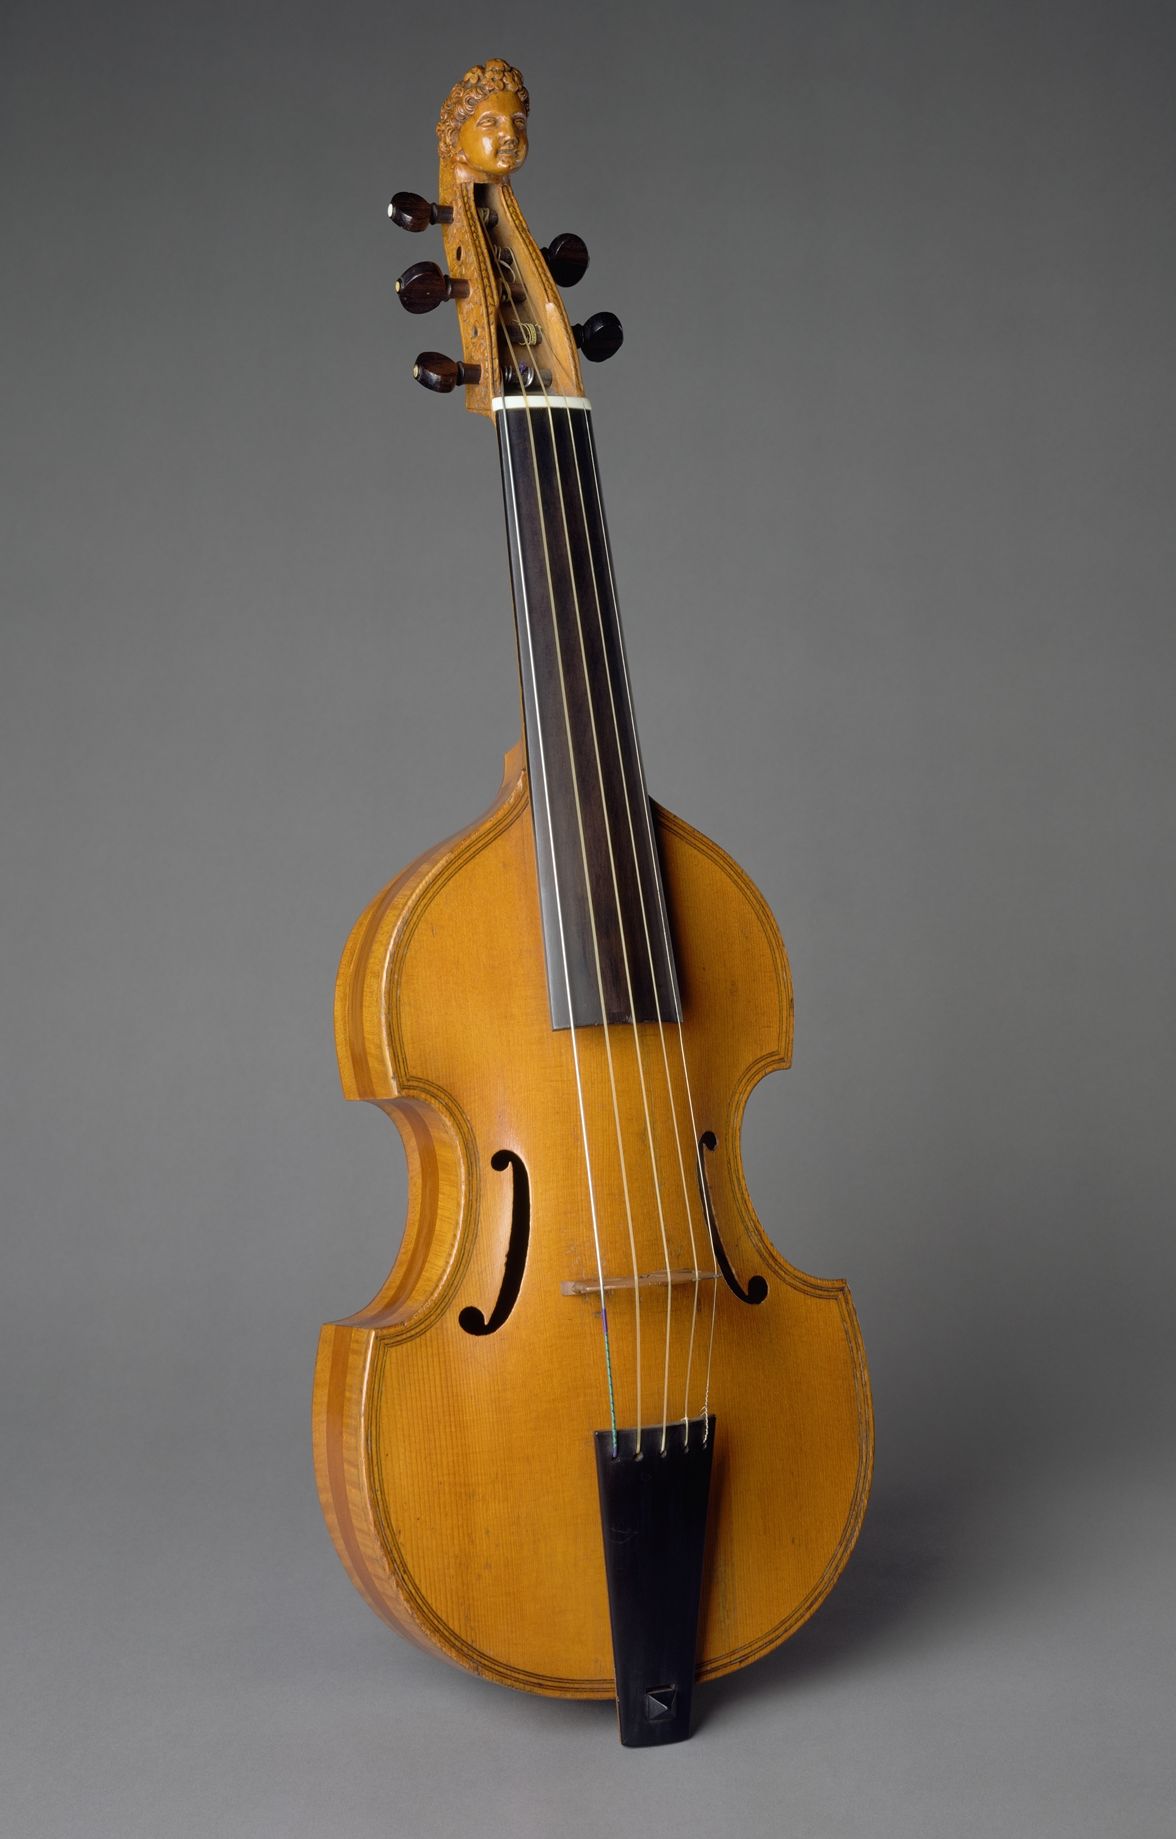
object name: pardessus de viole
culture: french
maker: louis guersan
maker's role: maker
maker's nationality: french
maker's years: 1713-1781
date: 1770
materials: wood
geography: france